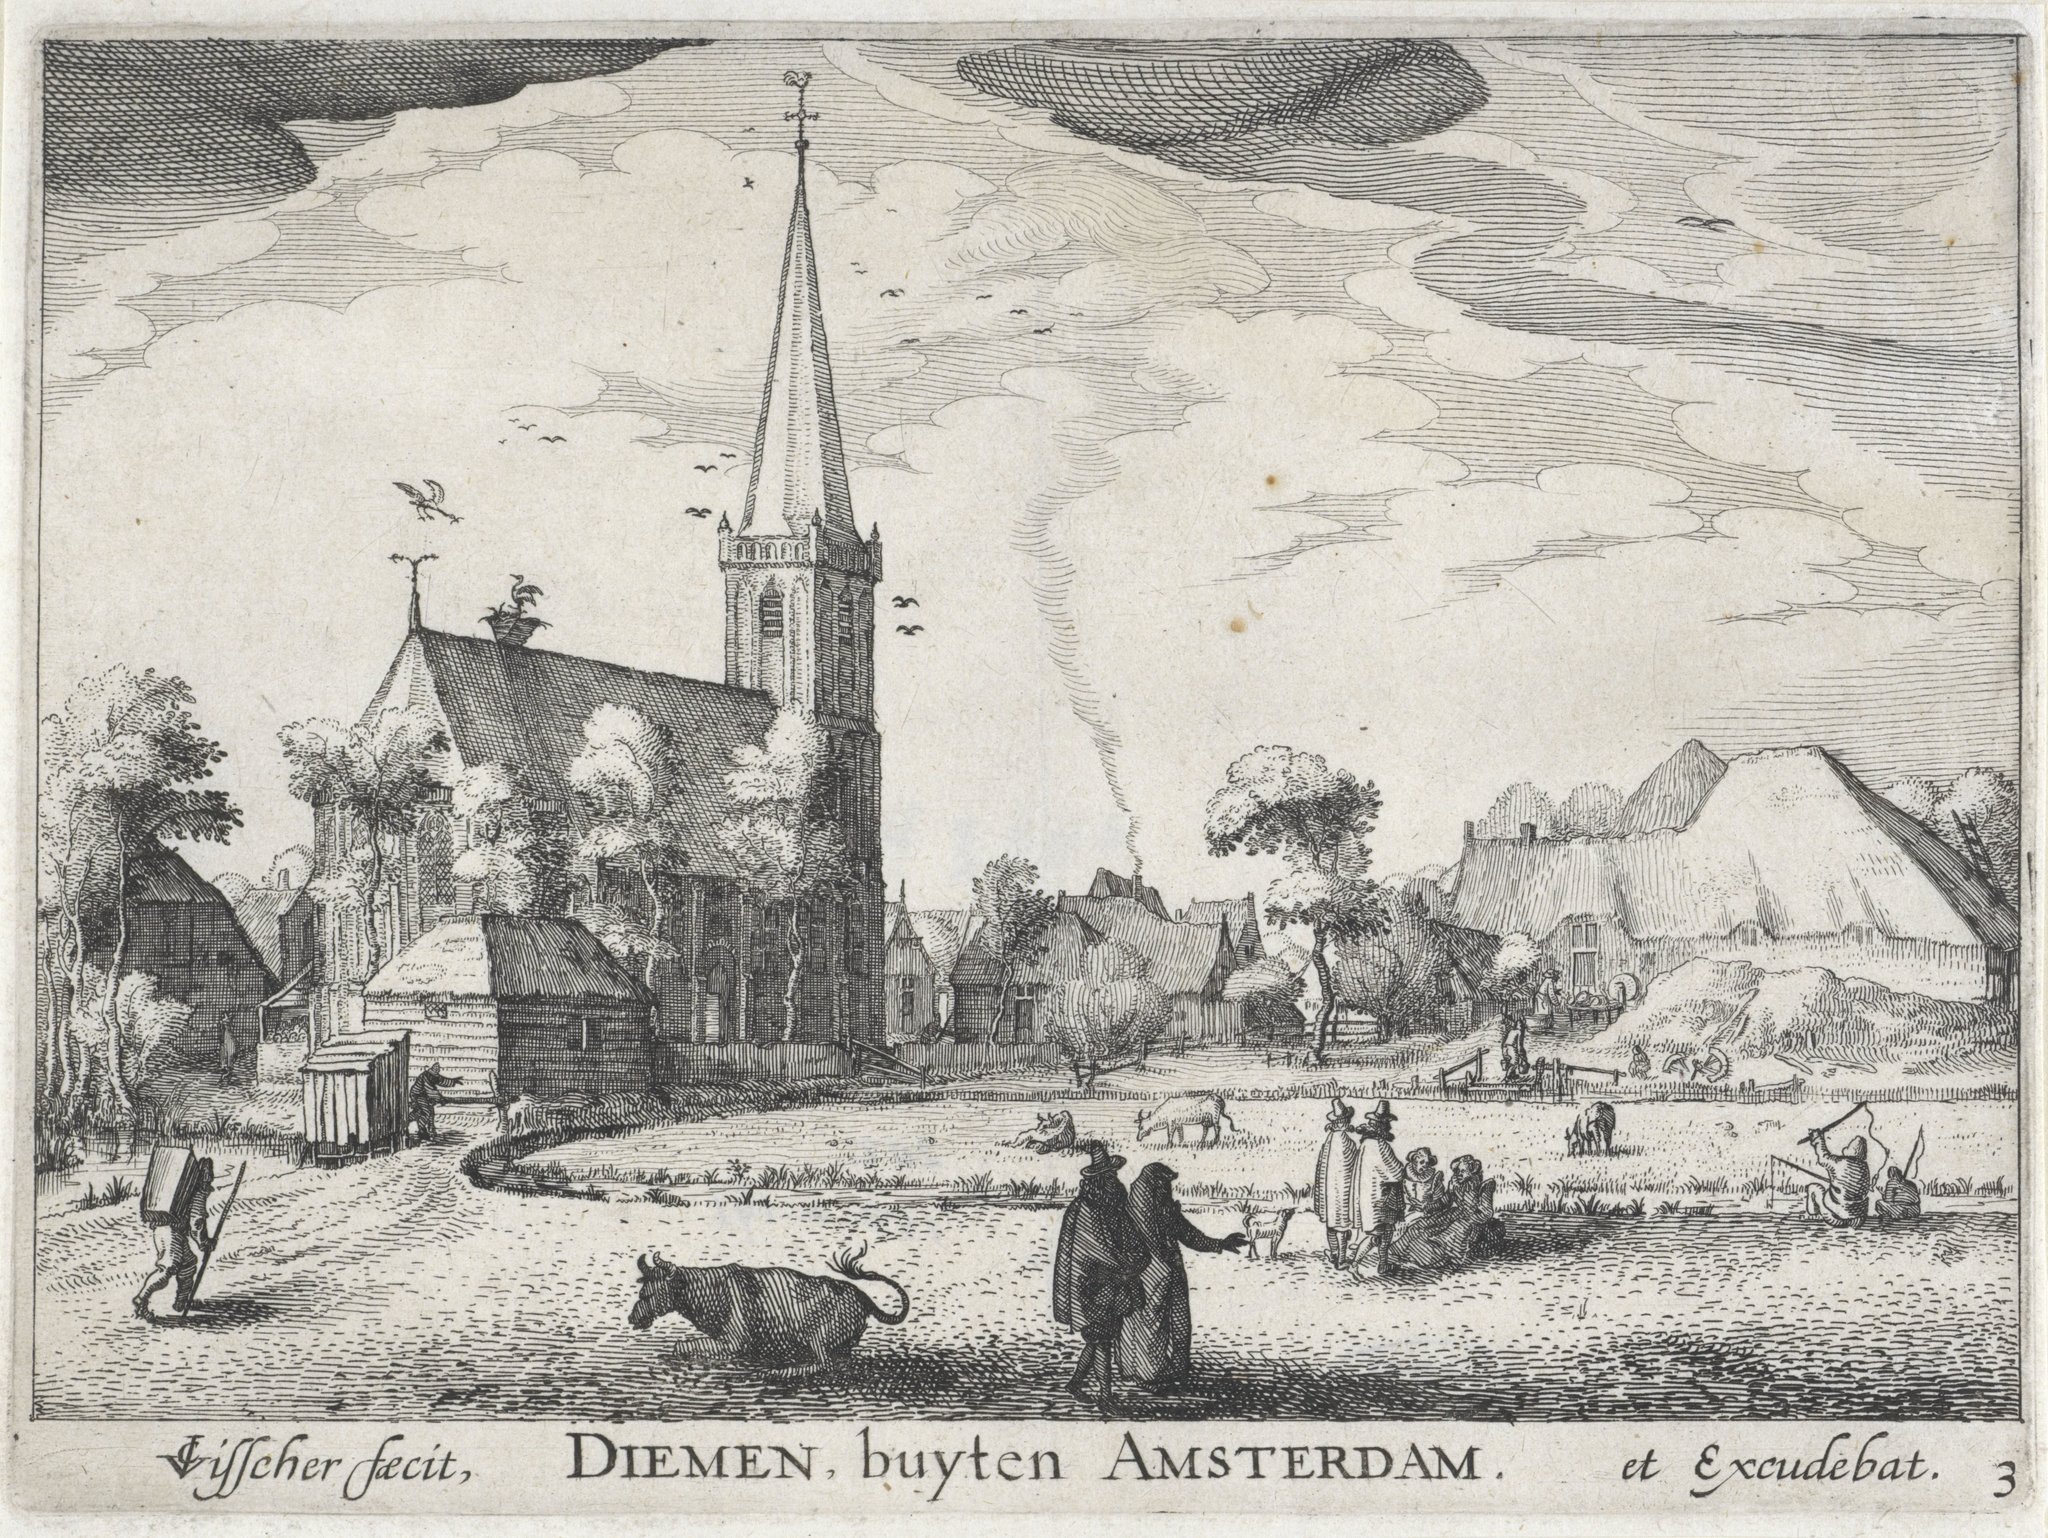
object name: print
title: Diemen, buyten Amsterdam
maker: claes jansz. visscher (ii)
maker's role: draughtsman, print maker, publisher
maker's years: 1586-1652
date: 1612-1652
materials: paper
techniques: engraving, etching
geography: amsterdam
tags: cow, church (exterior), farm (building)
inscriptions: collector's mark: Lugt 2228, title: ‘DIEMEN, buyten AMSTERDAM’, signature and address: ‘CIVisscher faecit et Excudebat.’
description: Gezicht op het dorp Diemen, met links de kerk en rechts een boerderij met een strooien dak. Op de voorgrond enkele mensen en grazend vee.